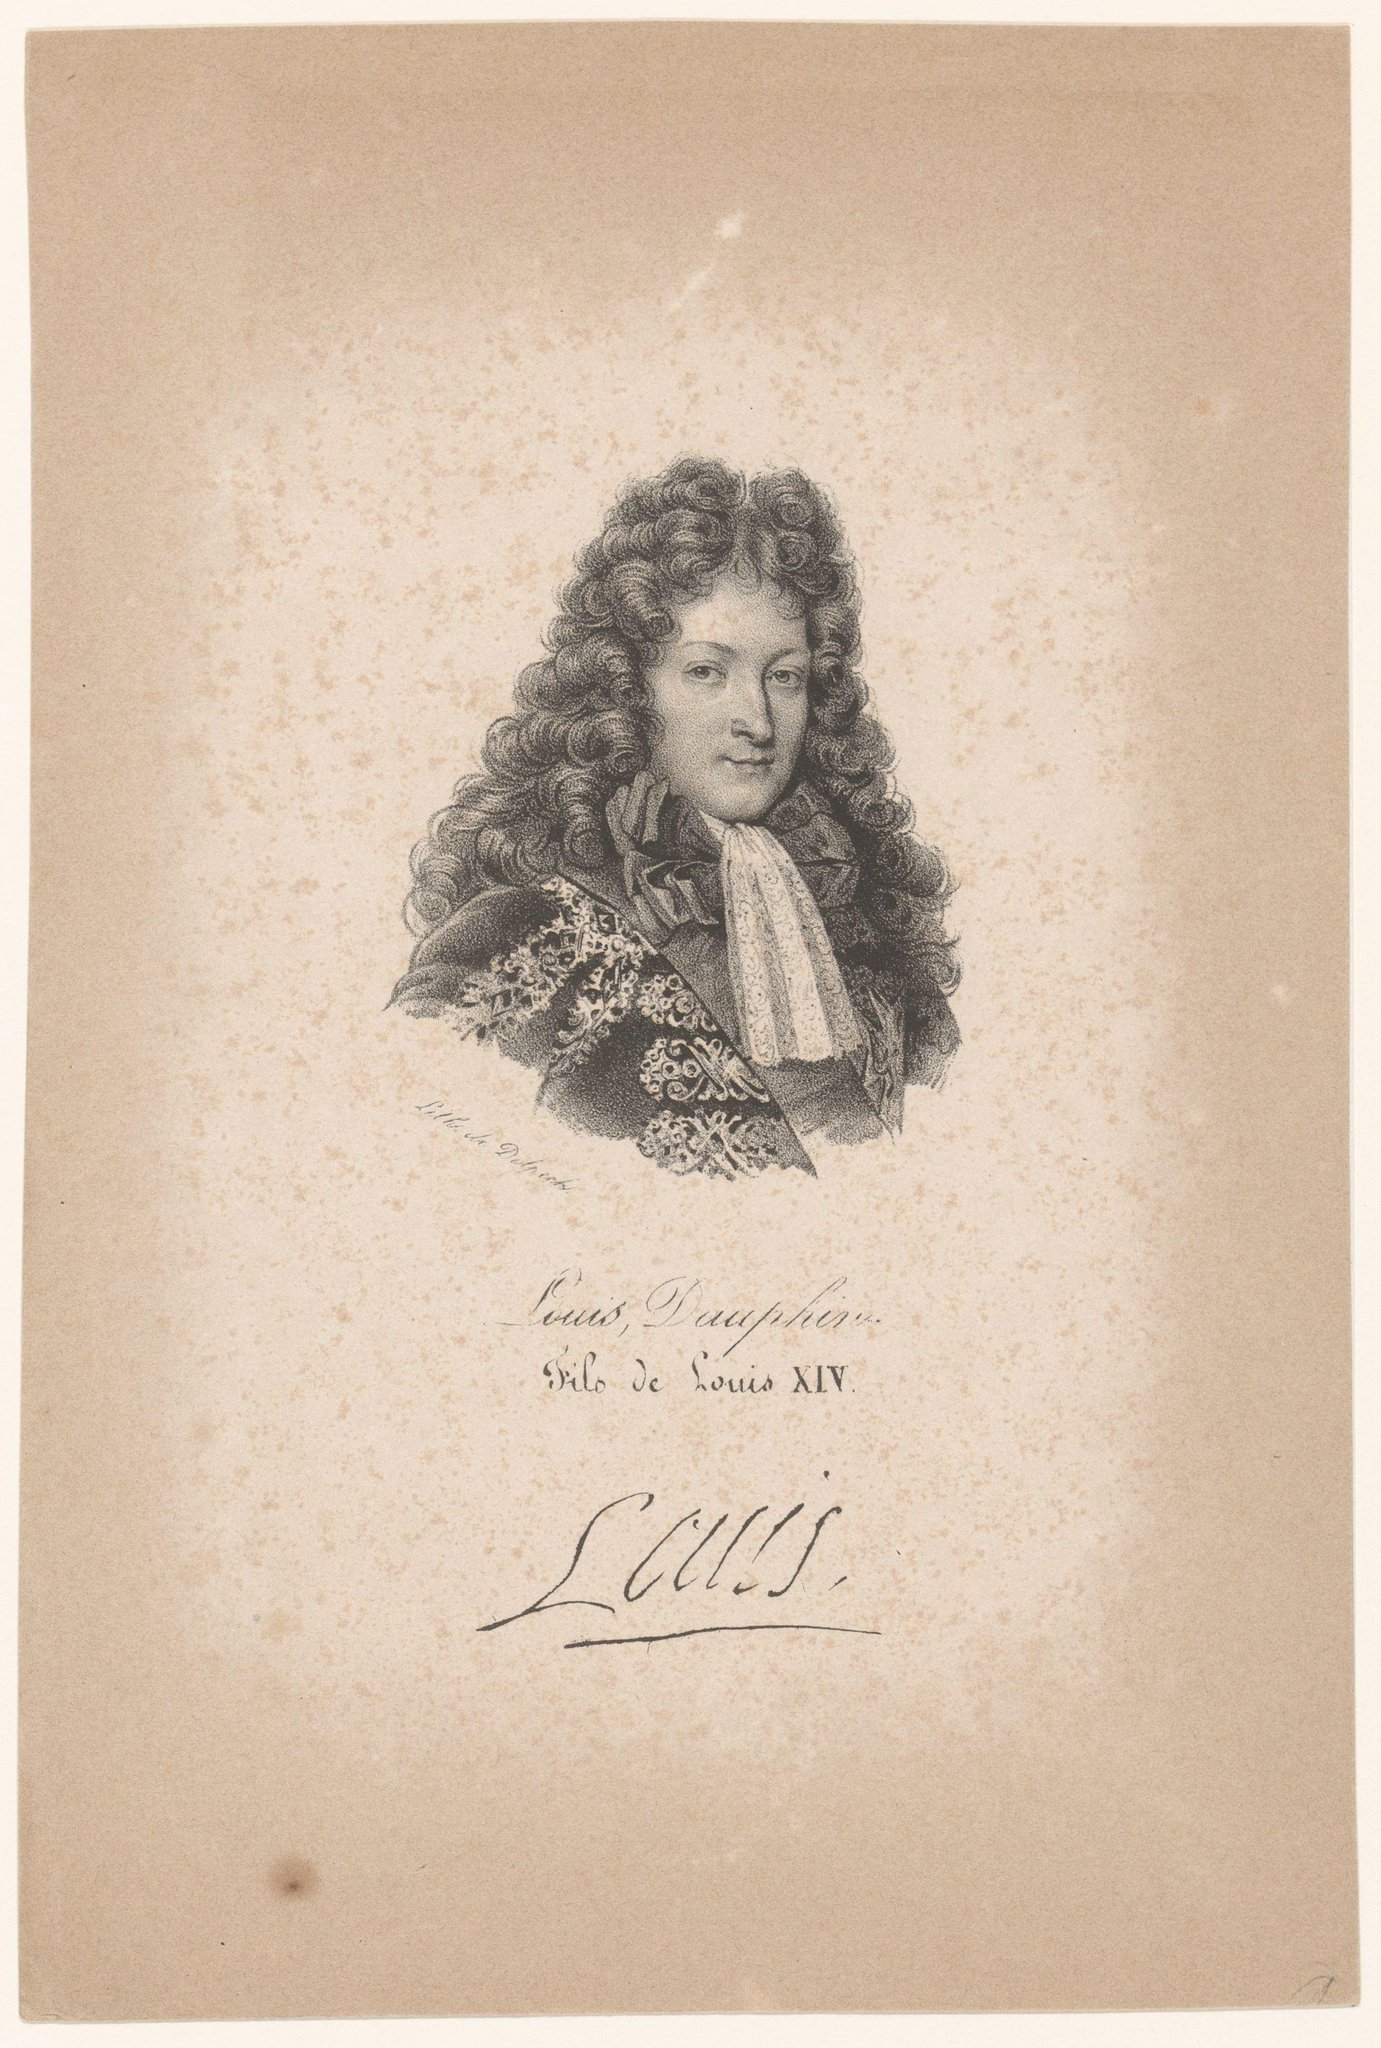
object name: print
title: Louis, Dauphin, fils de Louis XIV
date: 1818-1842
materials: paper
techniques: lithograph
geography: paris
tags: dauphin van frankrijk lodewijk, historical persons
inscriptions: collector's mark: Lugt 2228a